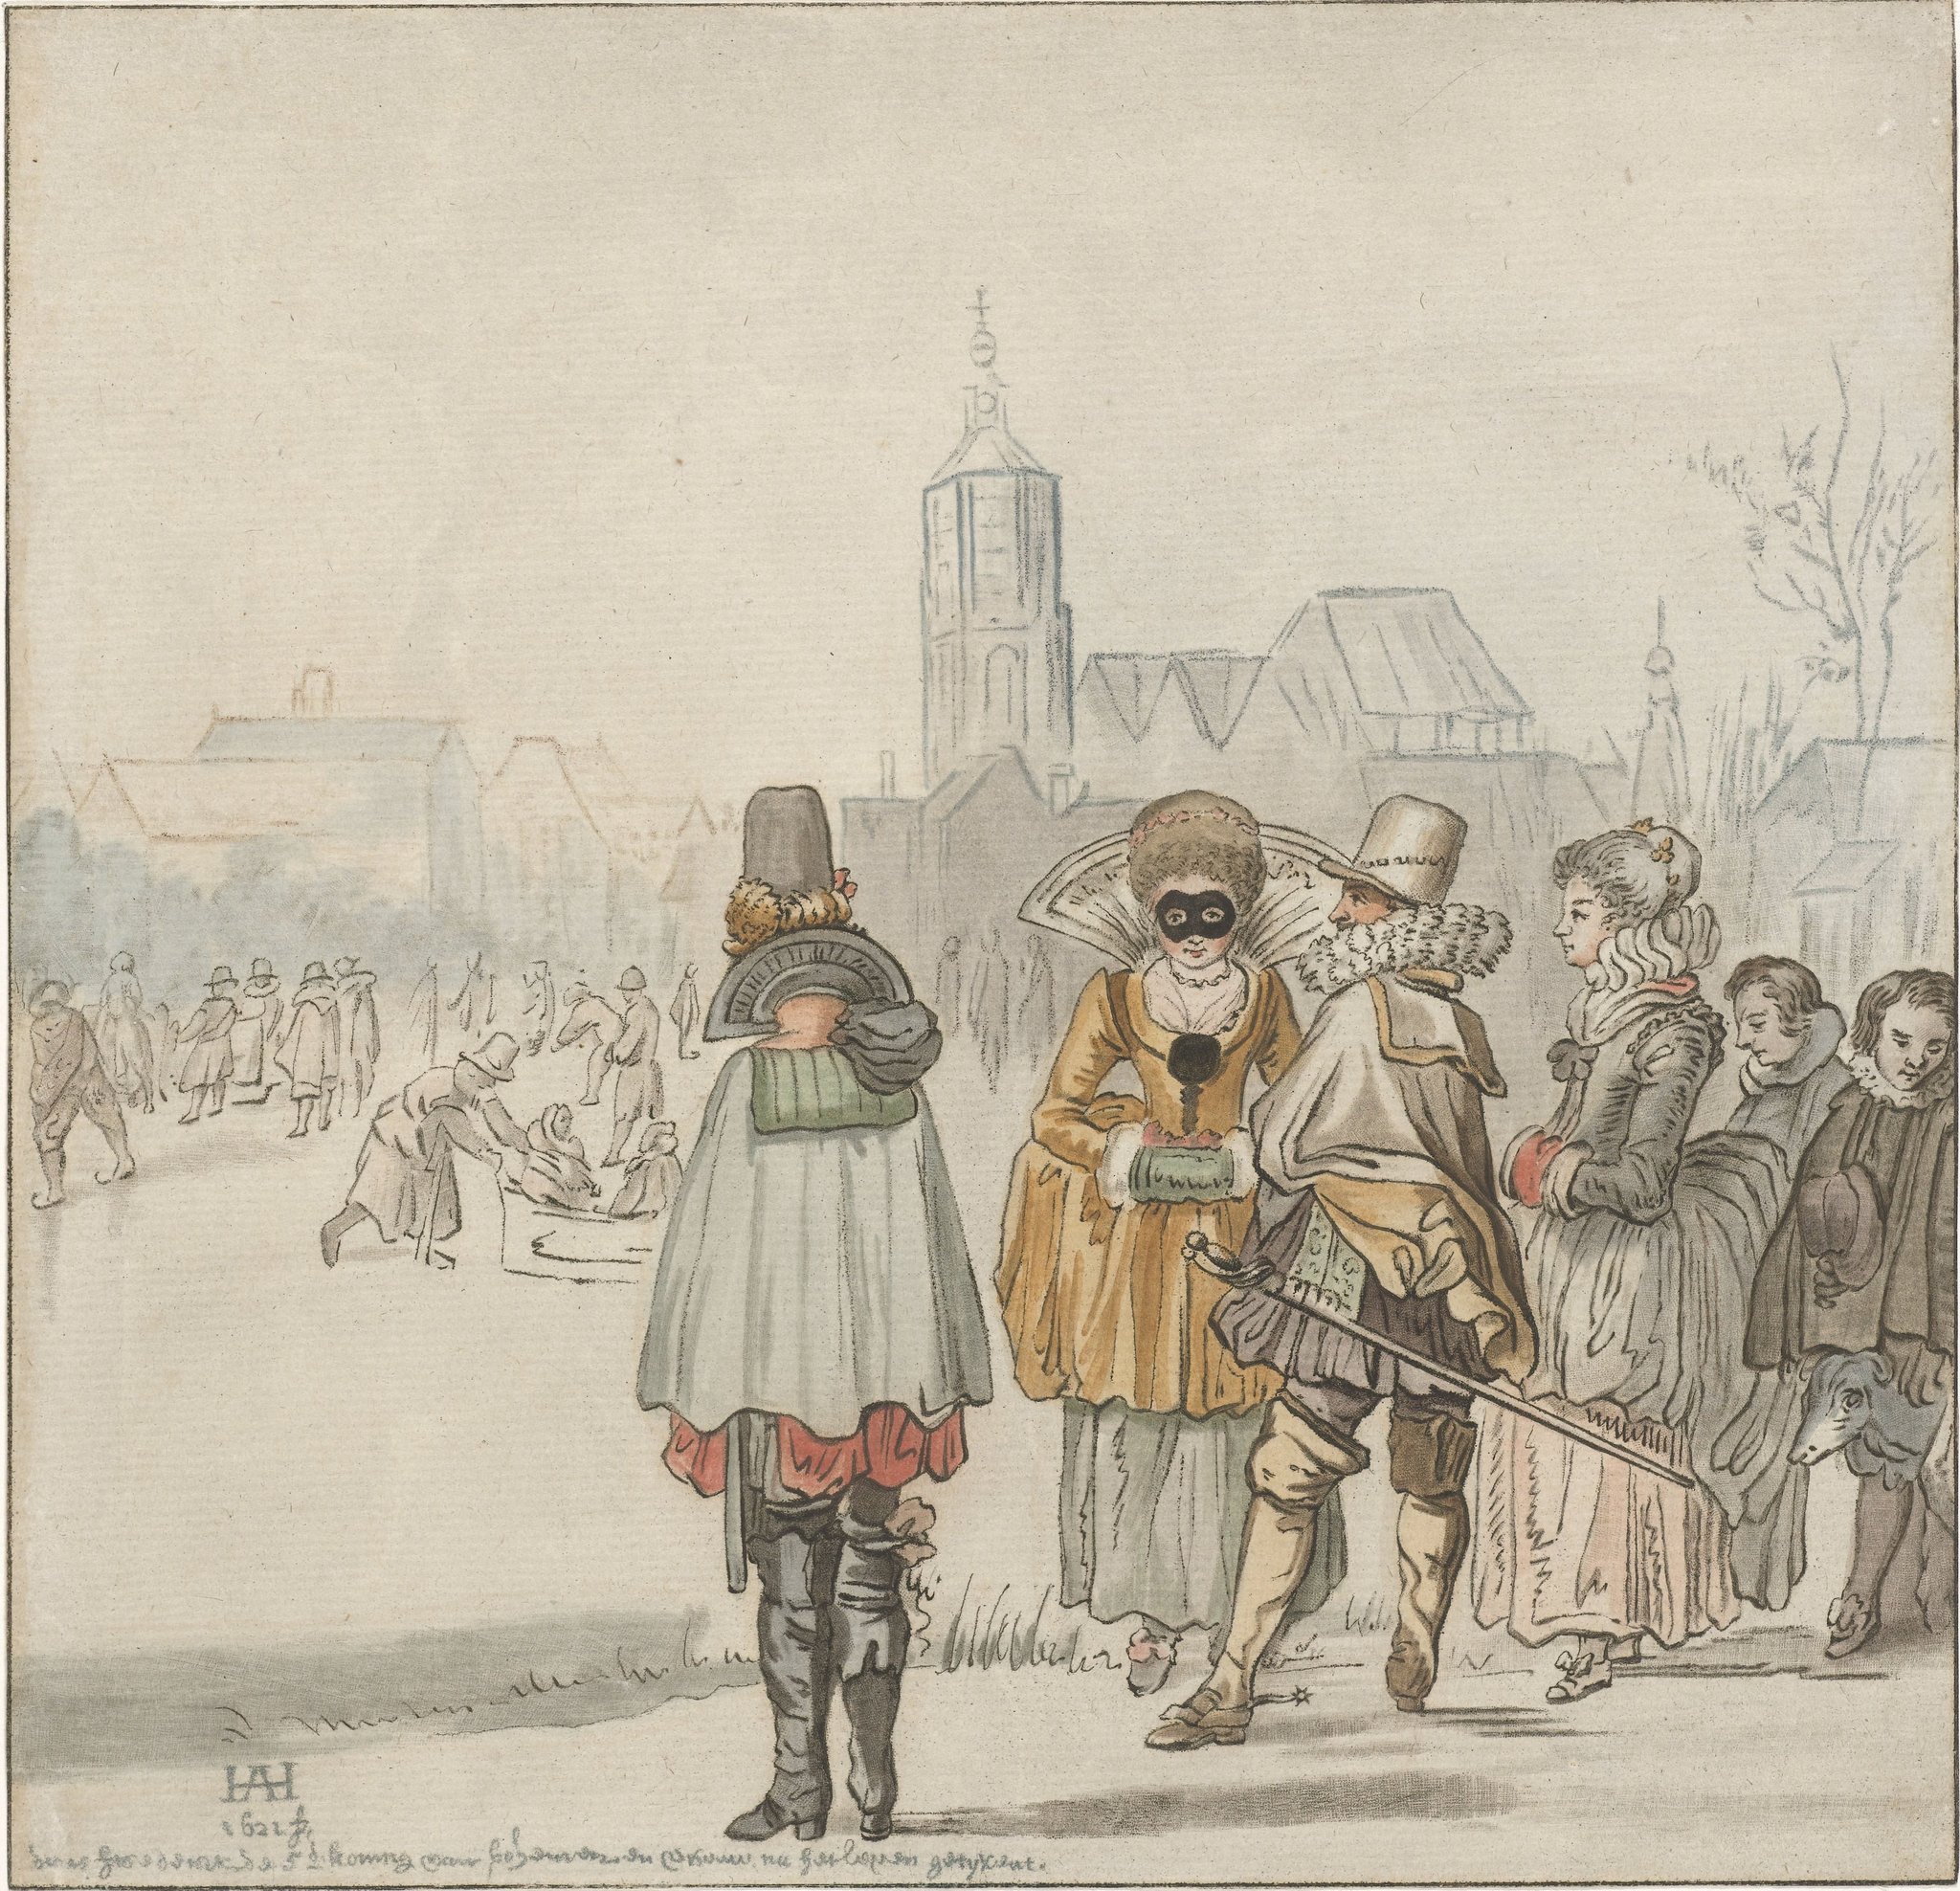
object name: print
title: Winterkoning op het ijs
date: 1766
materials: paper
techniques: etching, hand coloring, roulette, lithography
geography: amsterdam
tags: mask, winter sports, black velvet or satin mask, 'loup', 'cachenez' (+ women's clothes), muff, clothes, costume (+ women's clothes), clothes, costume (+ men's clothes), parts of church exterior and annexes: tower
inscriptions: inscription: ‘Hendr Avercamp, gebijnaamt de Stomme van Camoen. fecit 1621. Ploos van Amstel. f: 1766’, collector's mark: Lugt 2725, collector's mark: Lugt 240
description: Een rijk gekleed gezelschap, bestaande uit twee mannen en twee vrouwen, op het ijs.